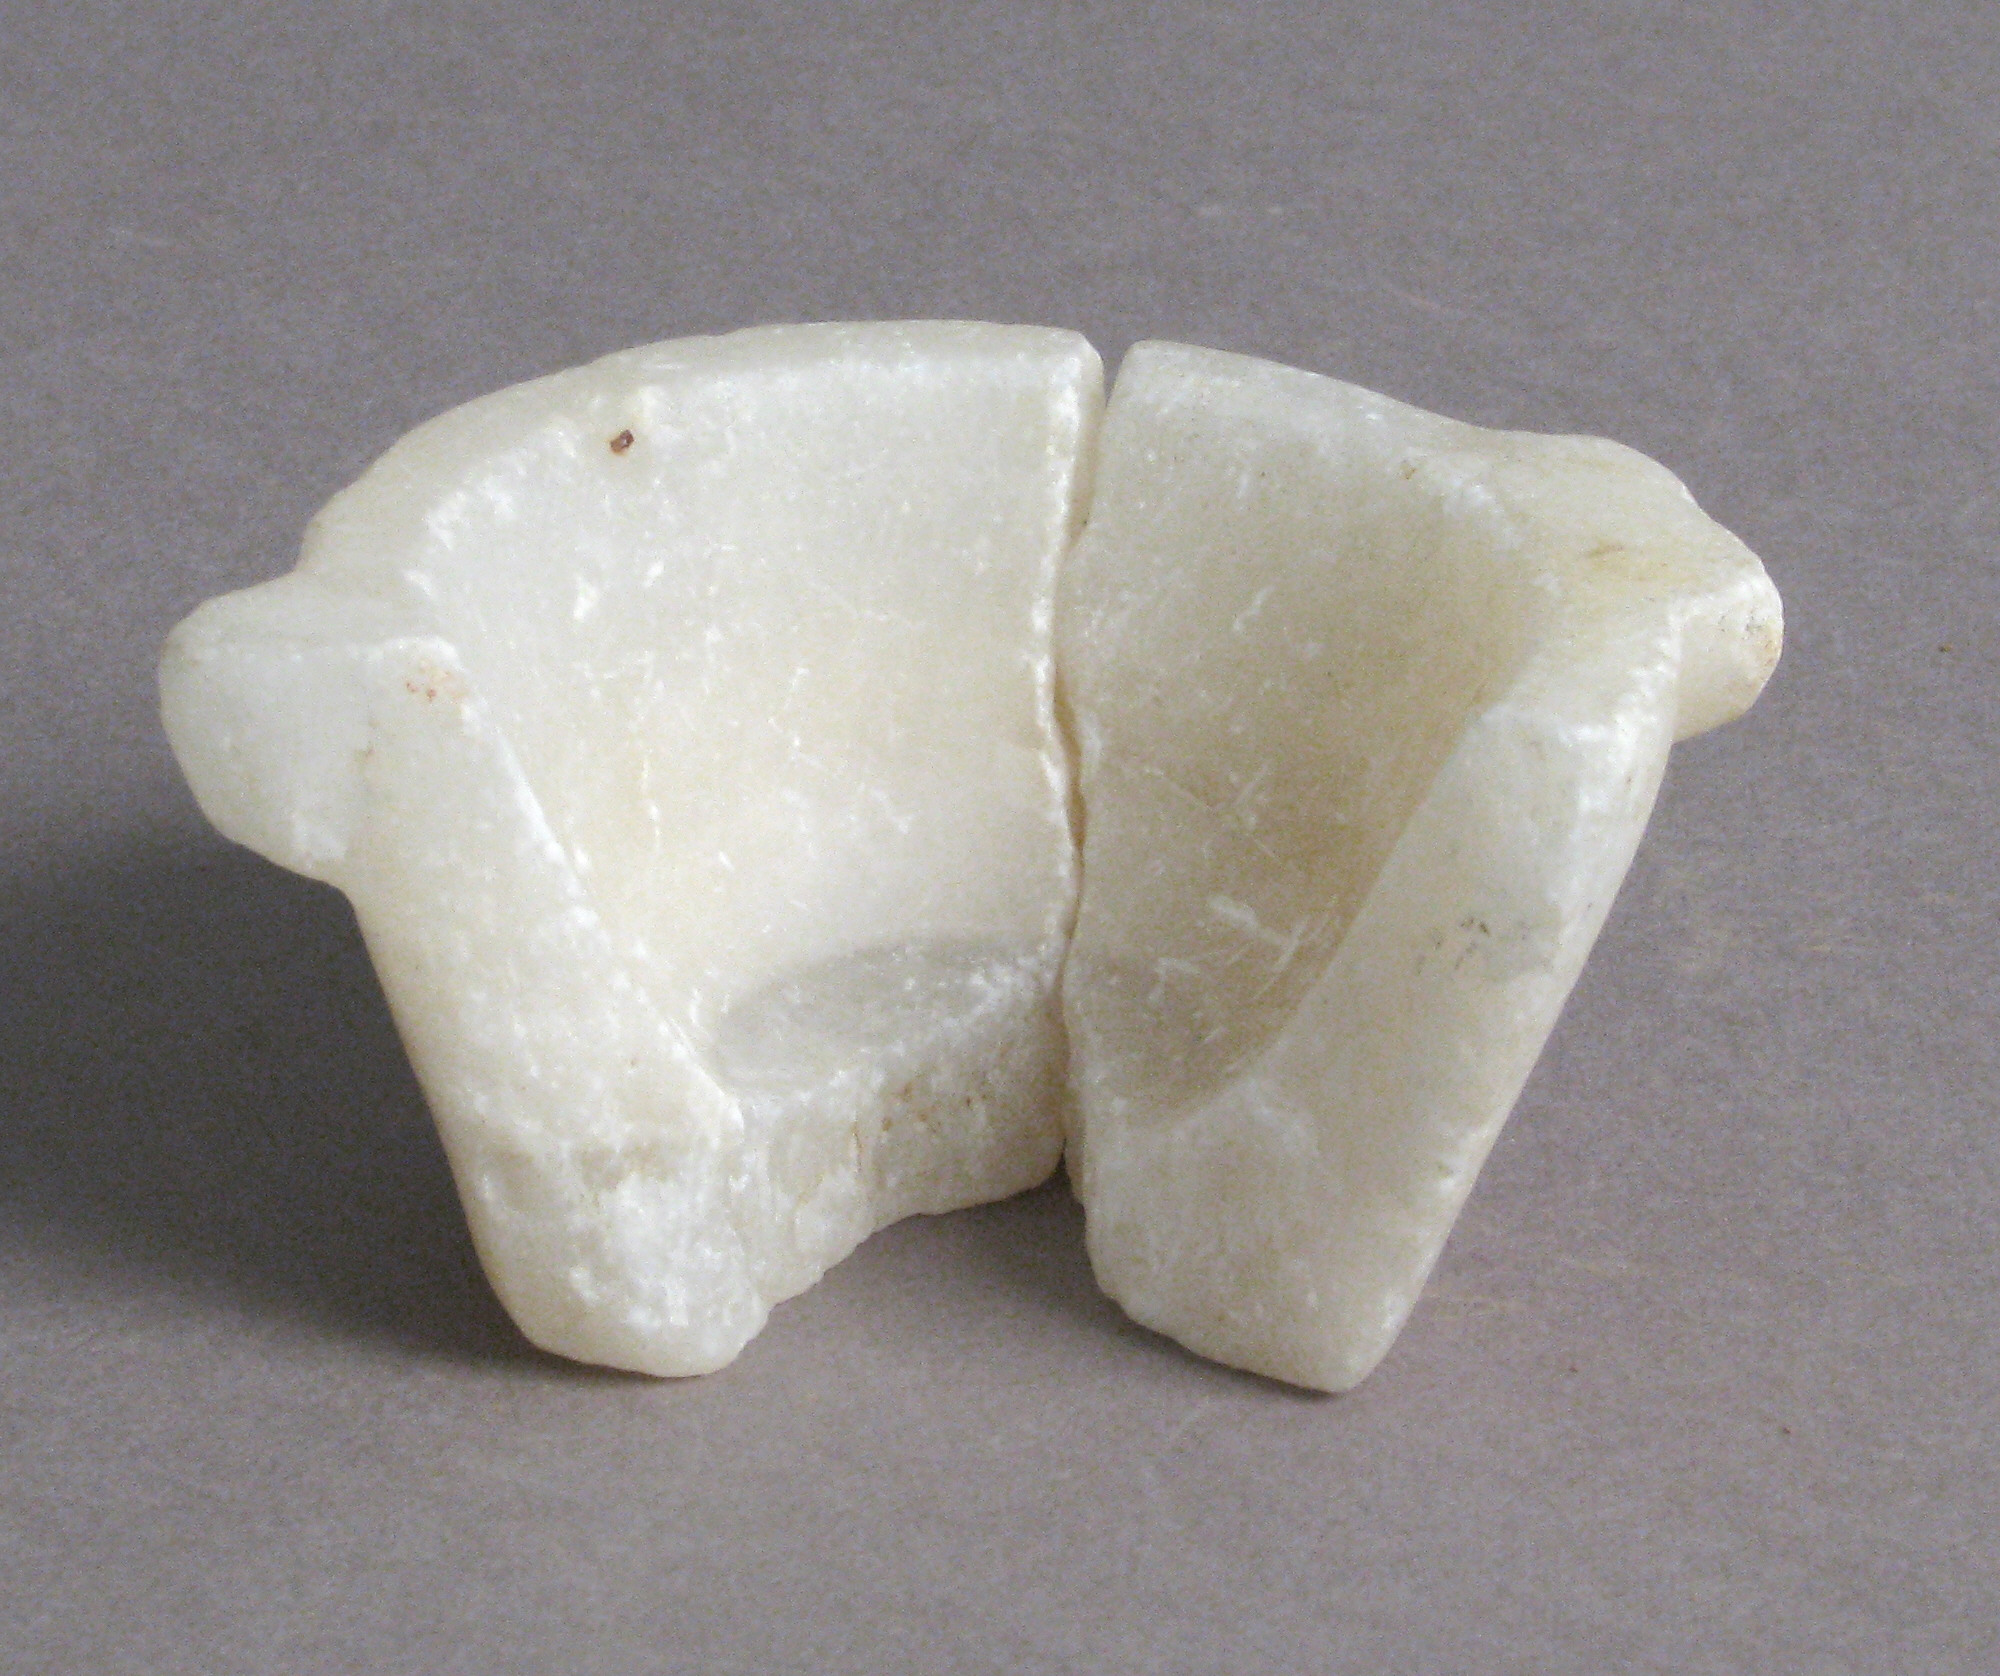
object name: vessel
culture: coptic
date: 301-700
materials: alabaster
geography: egypt